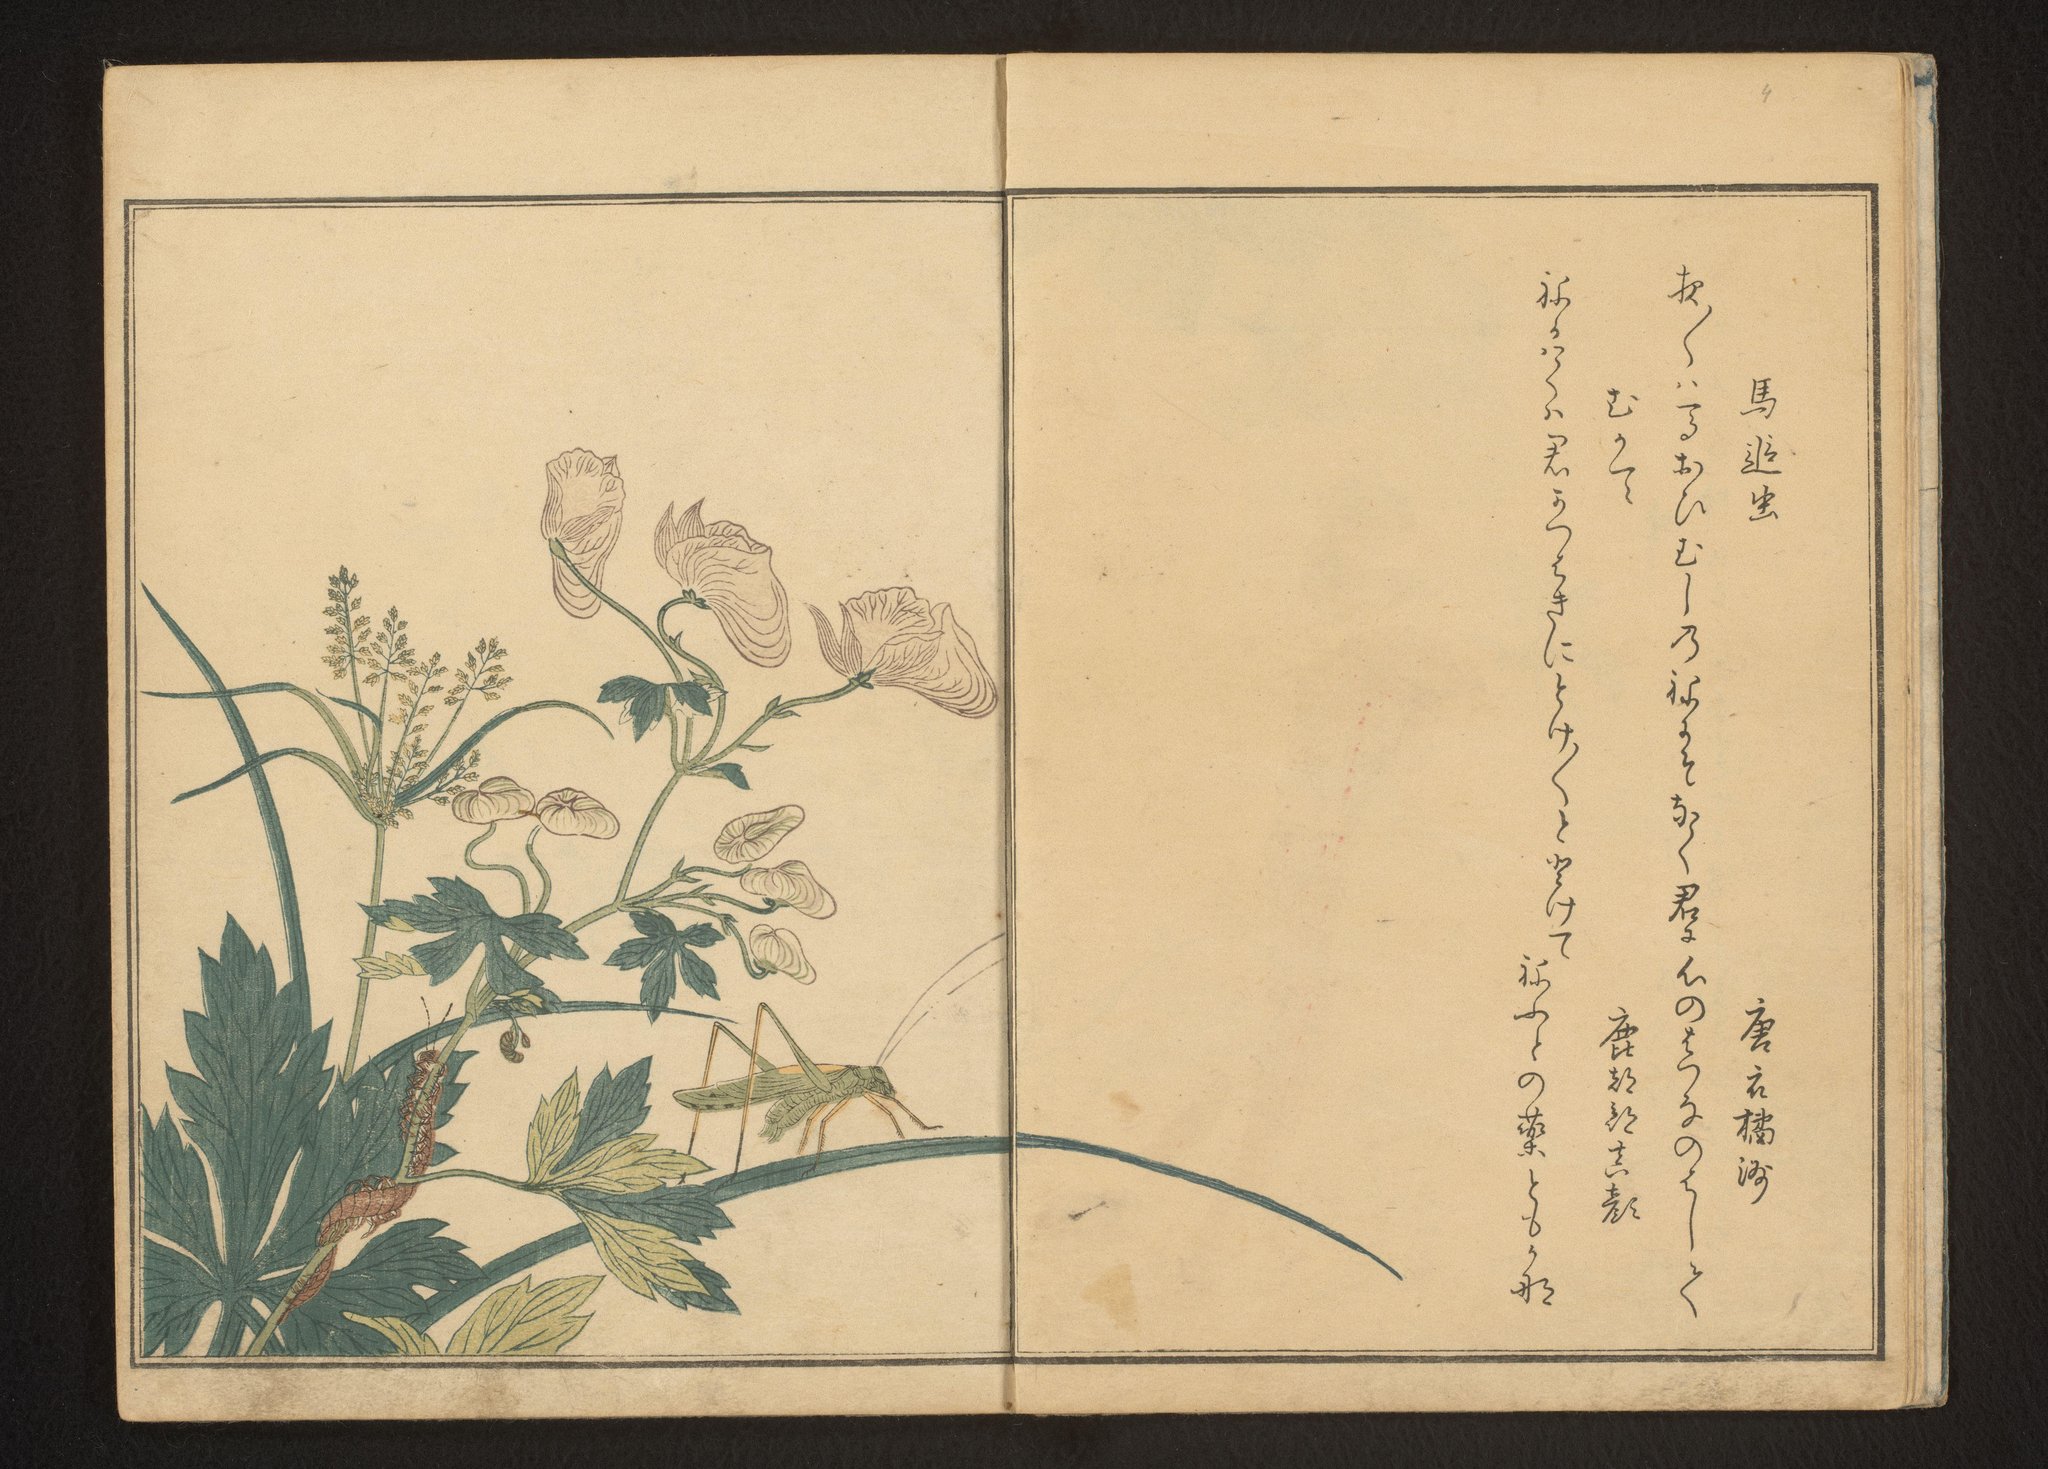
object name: page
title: Grasshopper and centipede on aconite plant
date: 1788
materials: paper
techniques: woodcut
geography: edo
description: Pagina 3b en 4a in deel één van het Insectenboek van Utamaro.